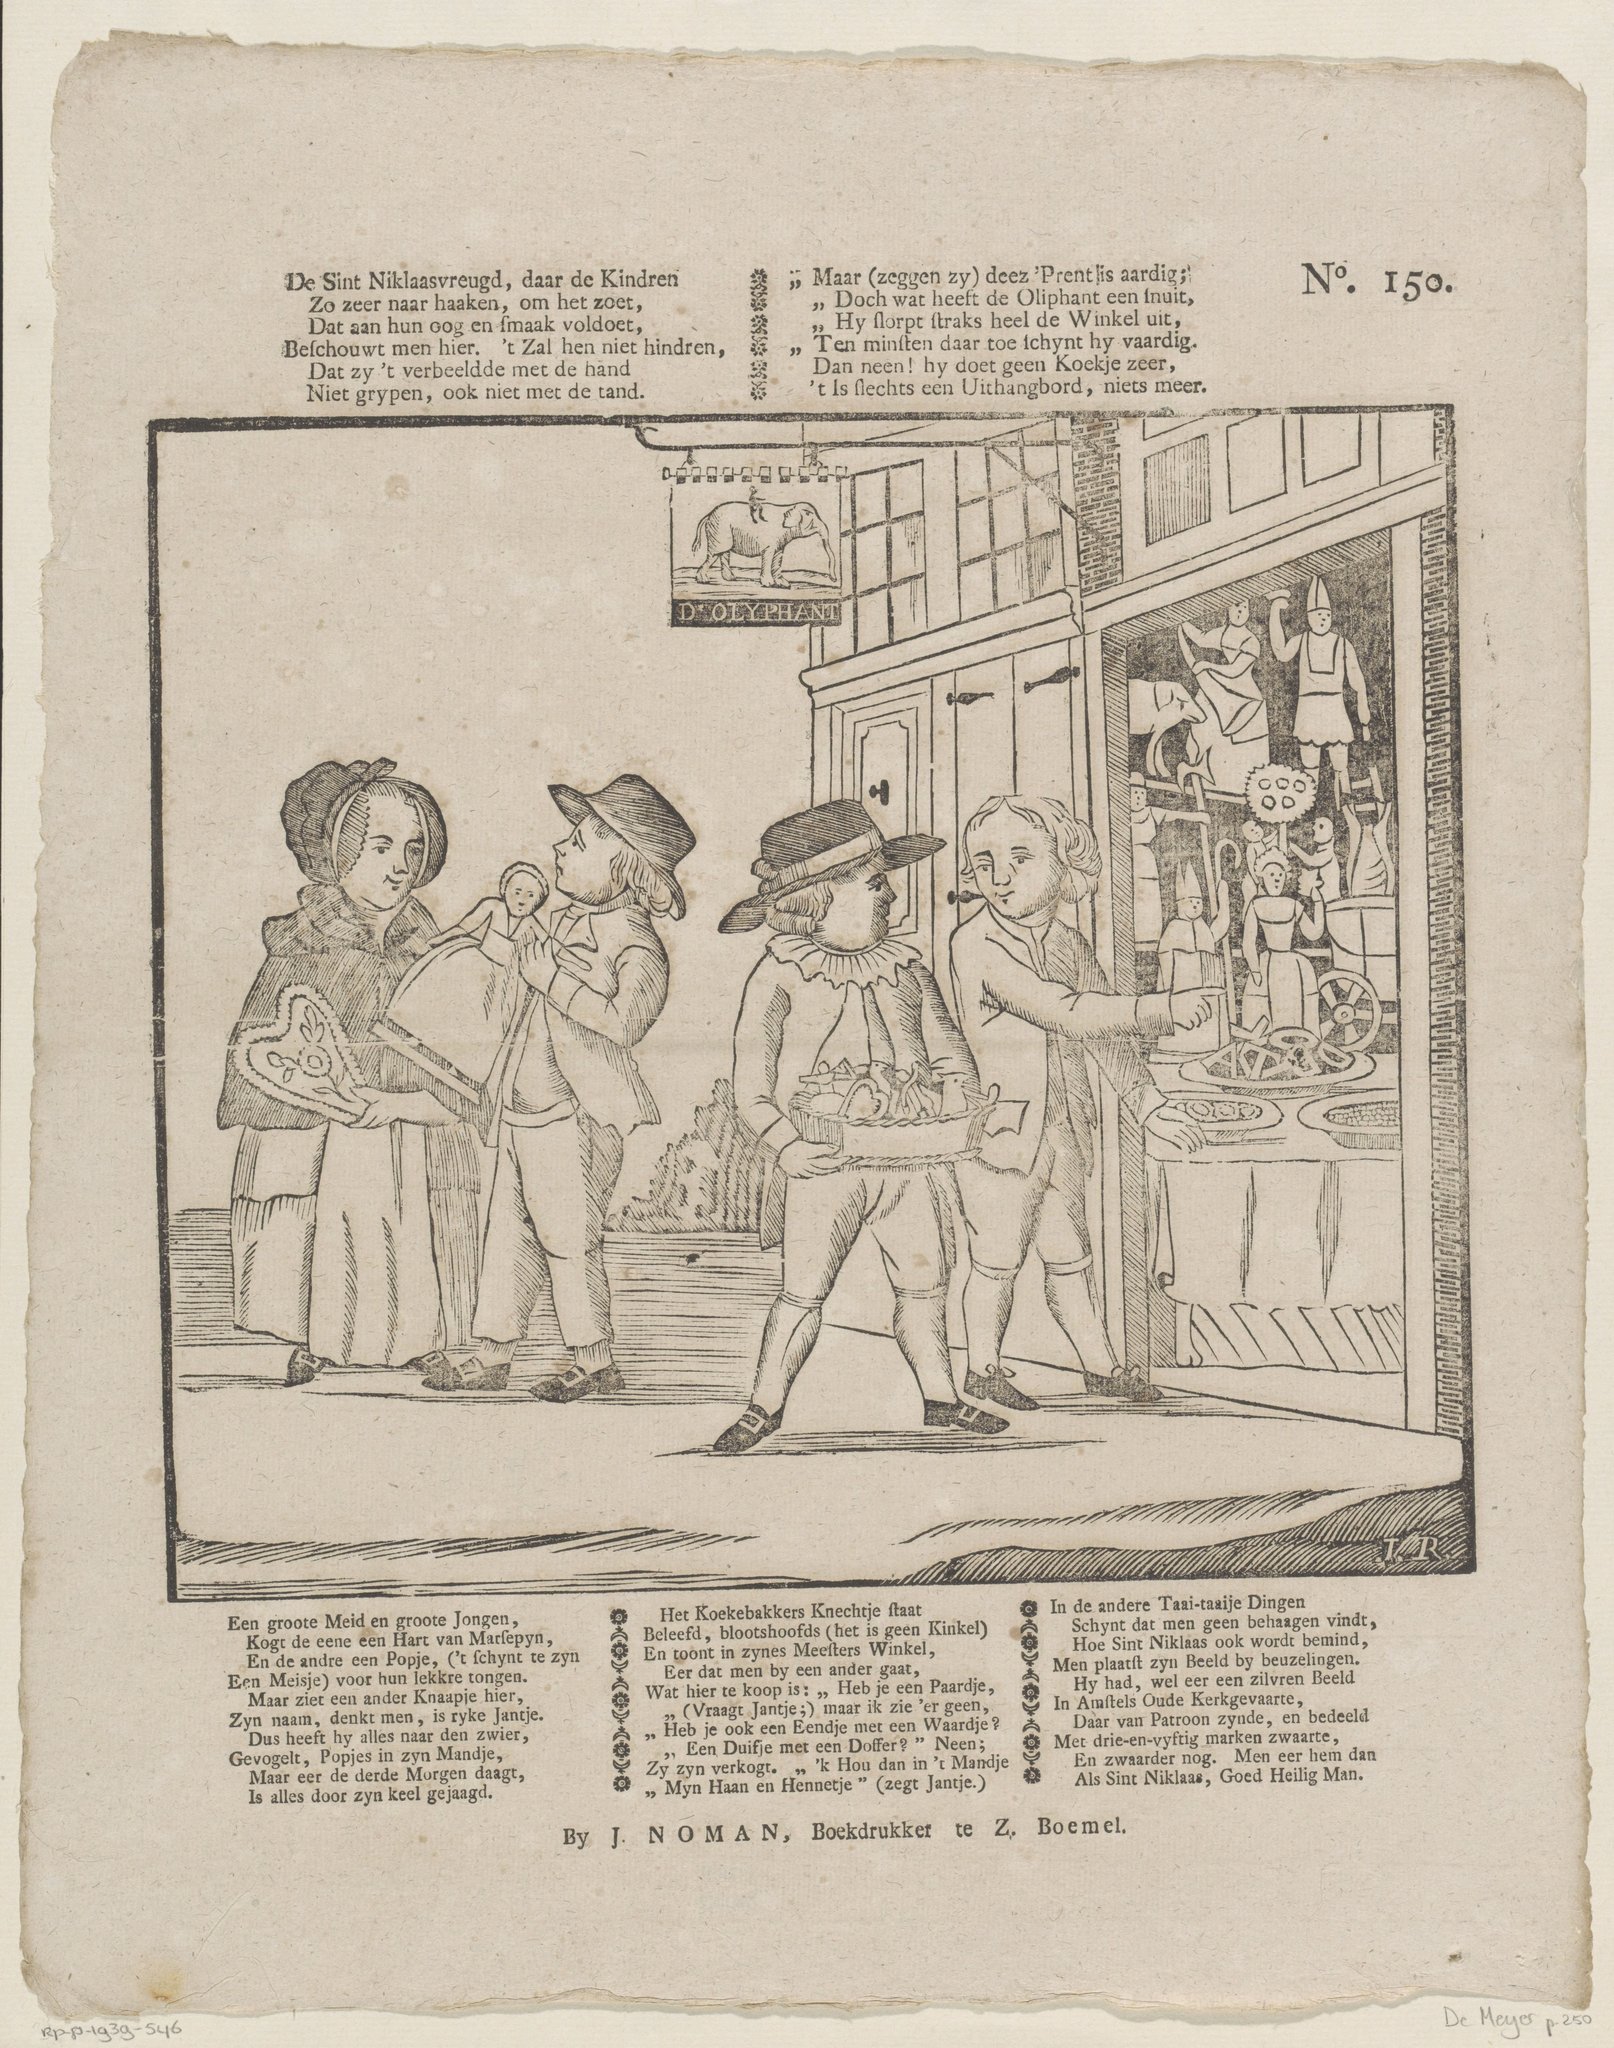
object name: popular print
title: De Sint Niklaasvreugd, daar de kindren / Zo zeer naar haaken, om het zoet (...)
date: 1806-1830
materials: paper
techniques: letterpress printing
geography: amsterdam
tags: the bishop nicholas of myra (or bari); possible attributes: anchor, boat, three golden balls (on a book), three purses, three children in a tub, three maidens, child, sugar-candy, (playing with) toys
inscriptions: collector's mark: Lugt 2166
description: Blad met een grote voorstelling van kinderen voor een winkel met snoepgoed en speelgoed voor het Sinterklaasfeest. Onder de afbeelding een vers in drie kolommen. Genummerd rechtsboven: No 150.